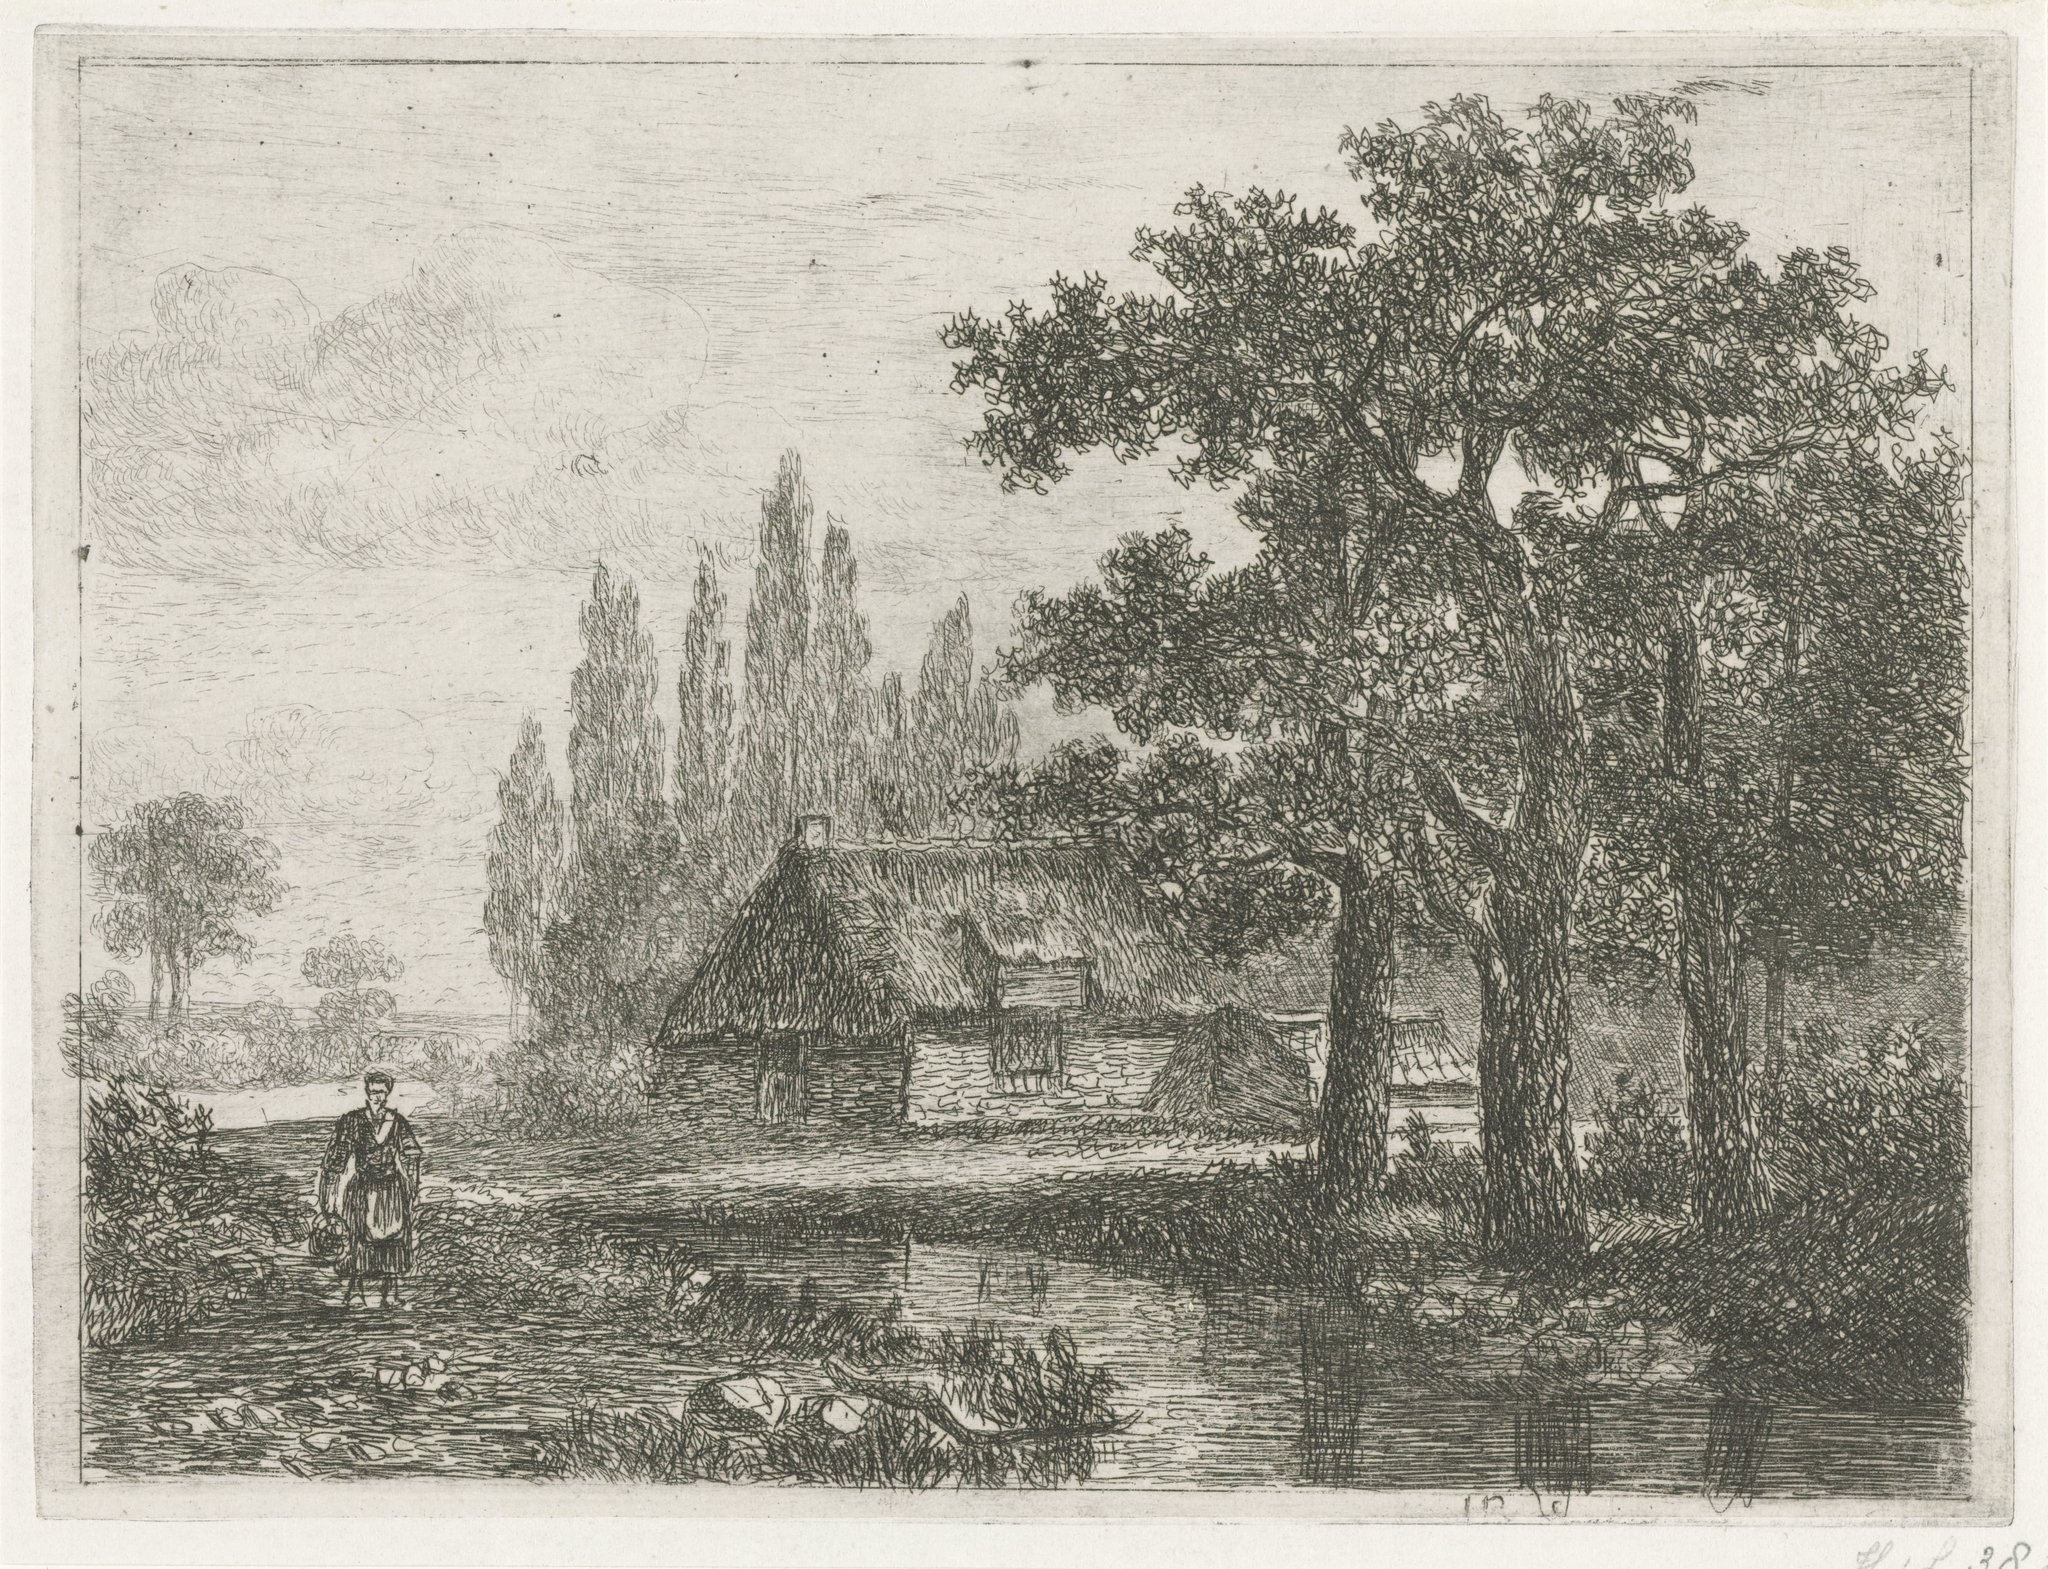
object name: print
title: Vrouw met een mand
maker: hermanus jan hendrik van rijkelijkhuysen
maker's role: painter, print maker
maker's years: 1813-1883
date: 1823-1883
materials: paper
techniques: drypoint, etching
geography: utrecht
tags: trees, river, farmers - aa - female farmer, farmer's wife, farm or solitary house in landscape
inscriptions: collector's mark: Lugt 2228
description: Gezicht op een landschap met bomen en een rivier met rechts een boerenhoeve. Op de voorgrond een vrouw met een mand.